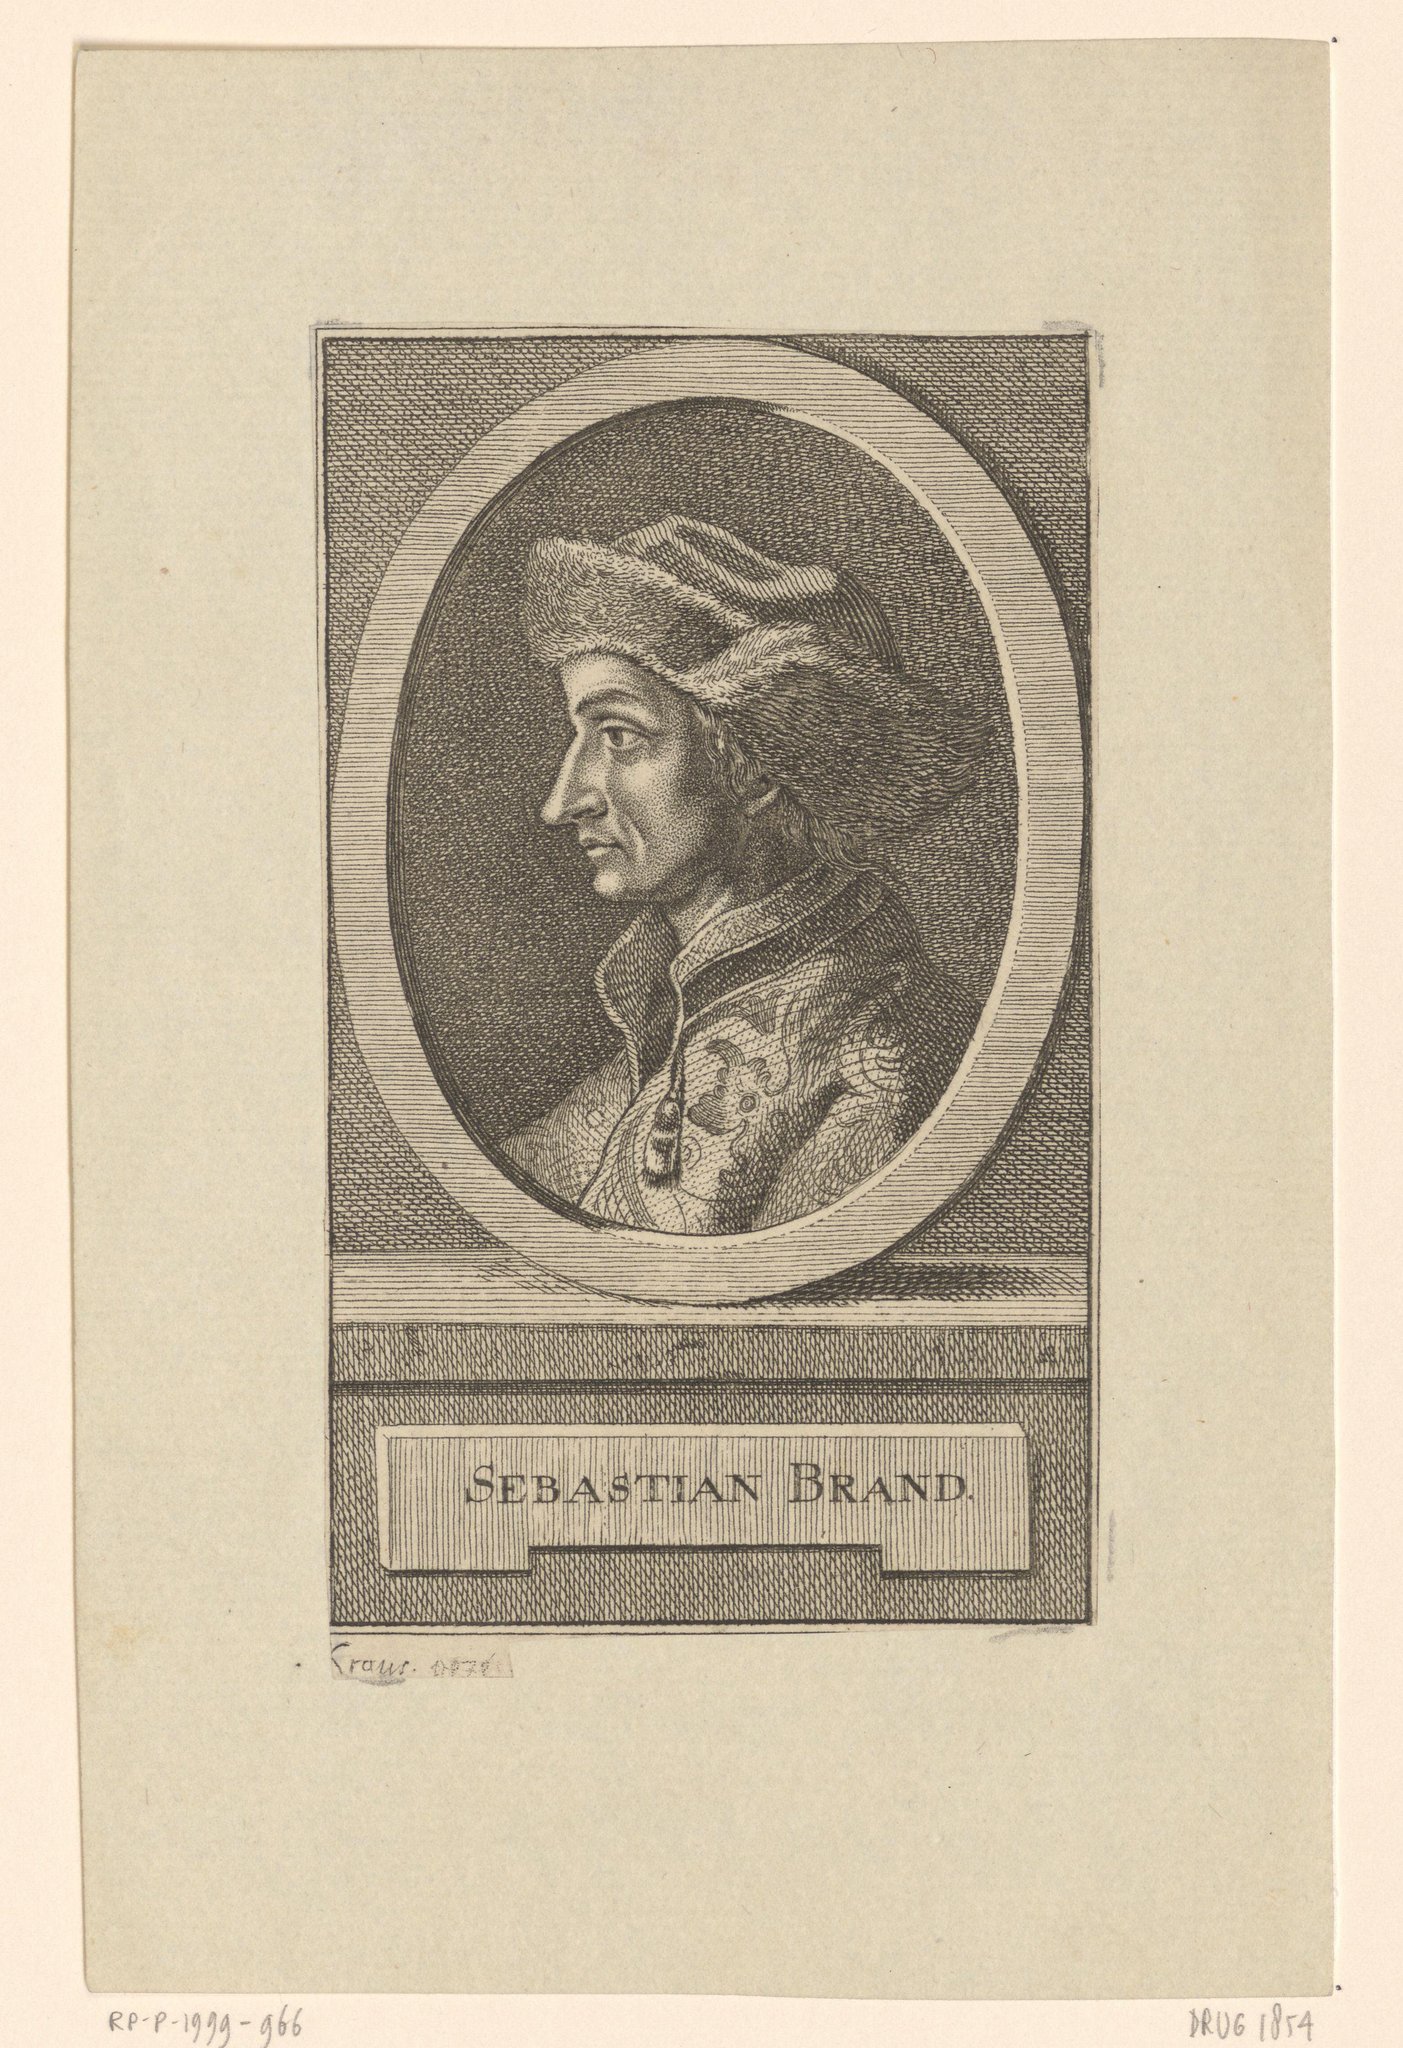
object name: print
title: Portret van Sebastian Brand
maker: georg melchior kraus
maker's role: painter, print maker, publisher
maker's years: 1737-1806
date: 1747-1806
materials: paper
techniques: etching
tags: historical persons, portrait of a writer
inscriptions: collector's mark: Lugt 2760, collector's mark: Lugt 2228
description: Prent mogelijk uit: Der Teutsche Merkur vom Jahr 1776. Weimar: s.n., 1776.